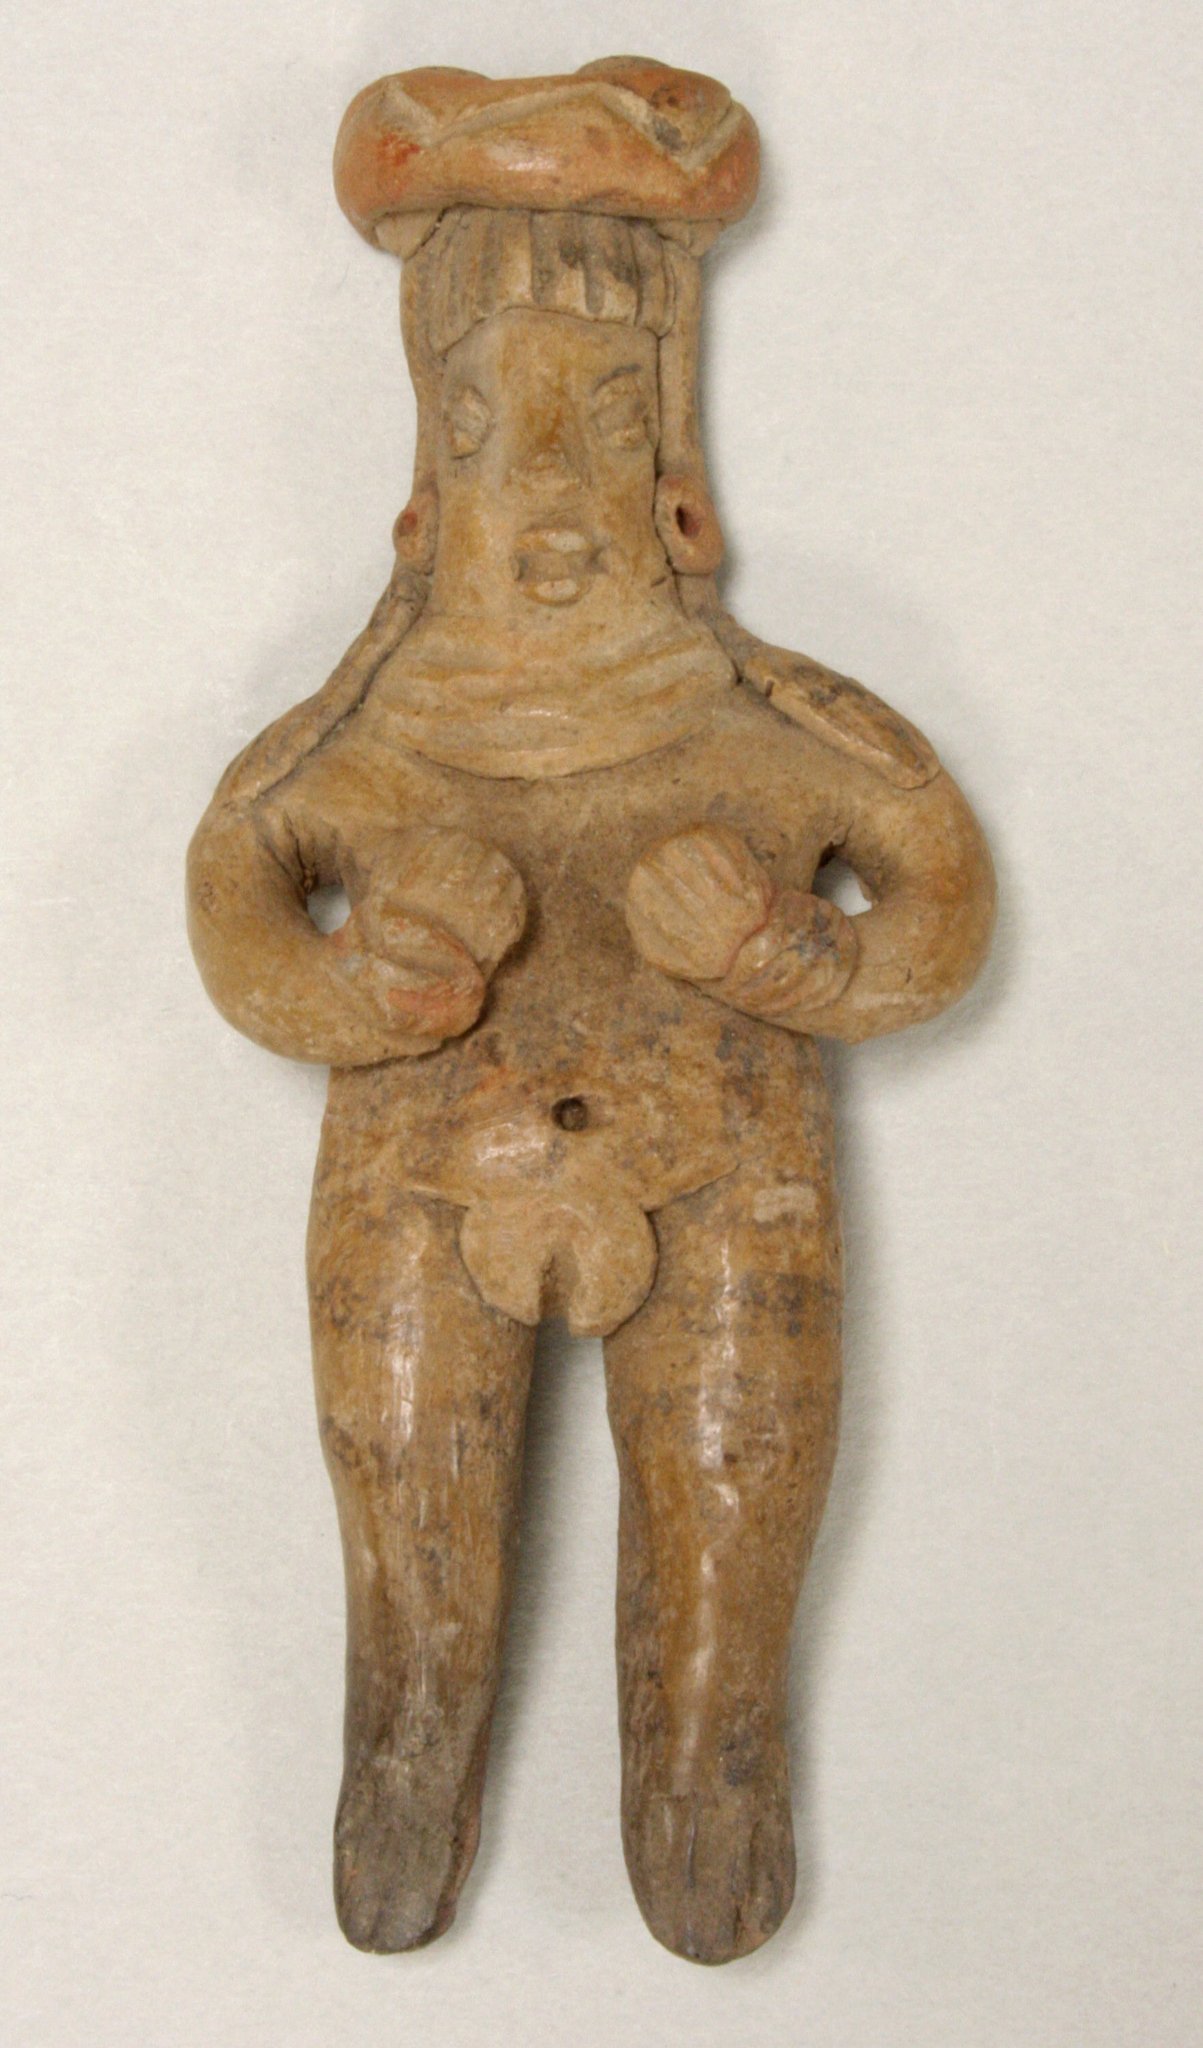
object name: female figure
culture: chupicuaro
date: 300 BCE-400 CE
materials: ceramic, pigment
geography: mexico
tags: female nudes